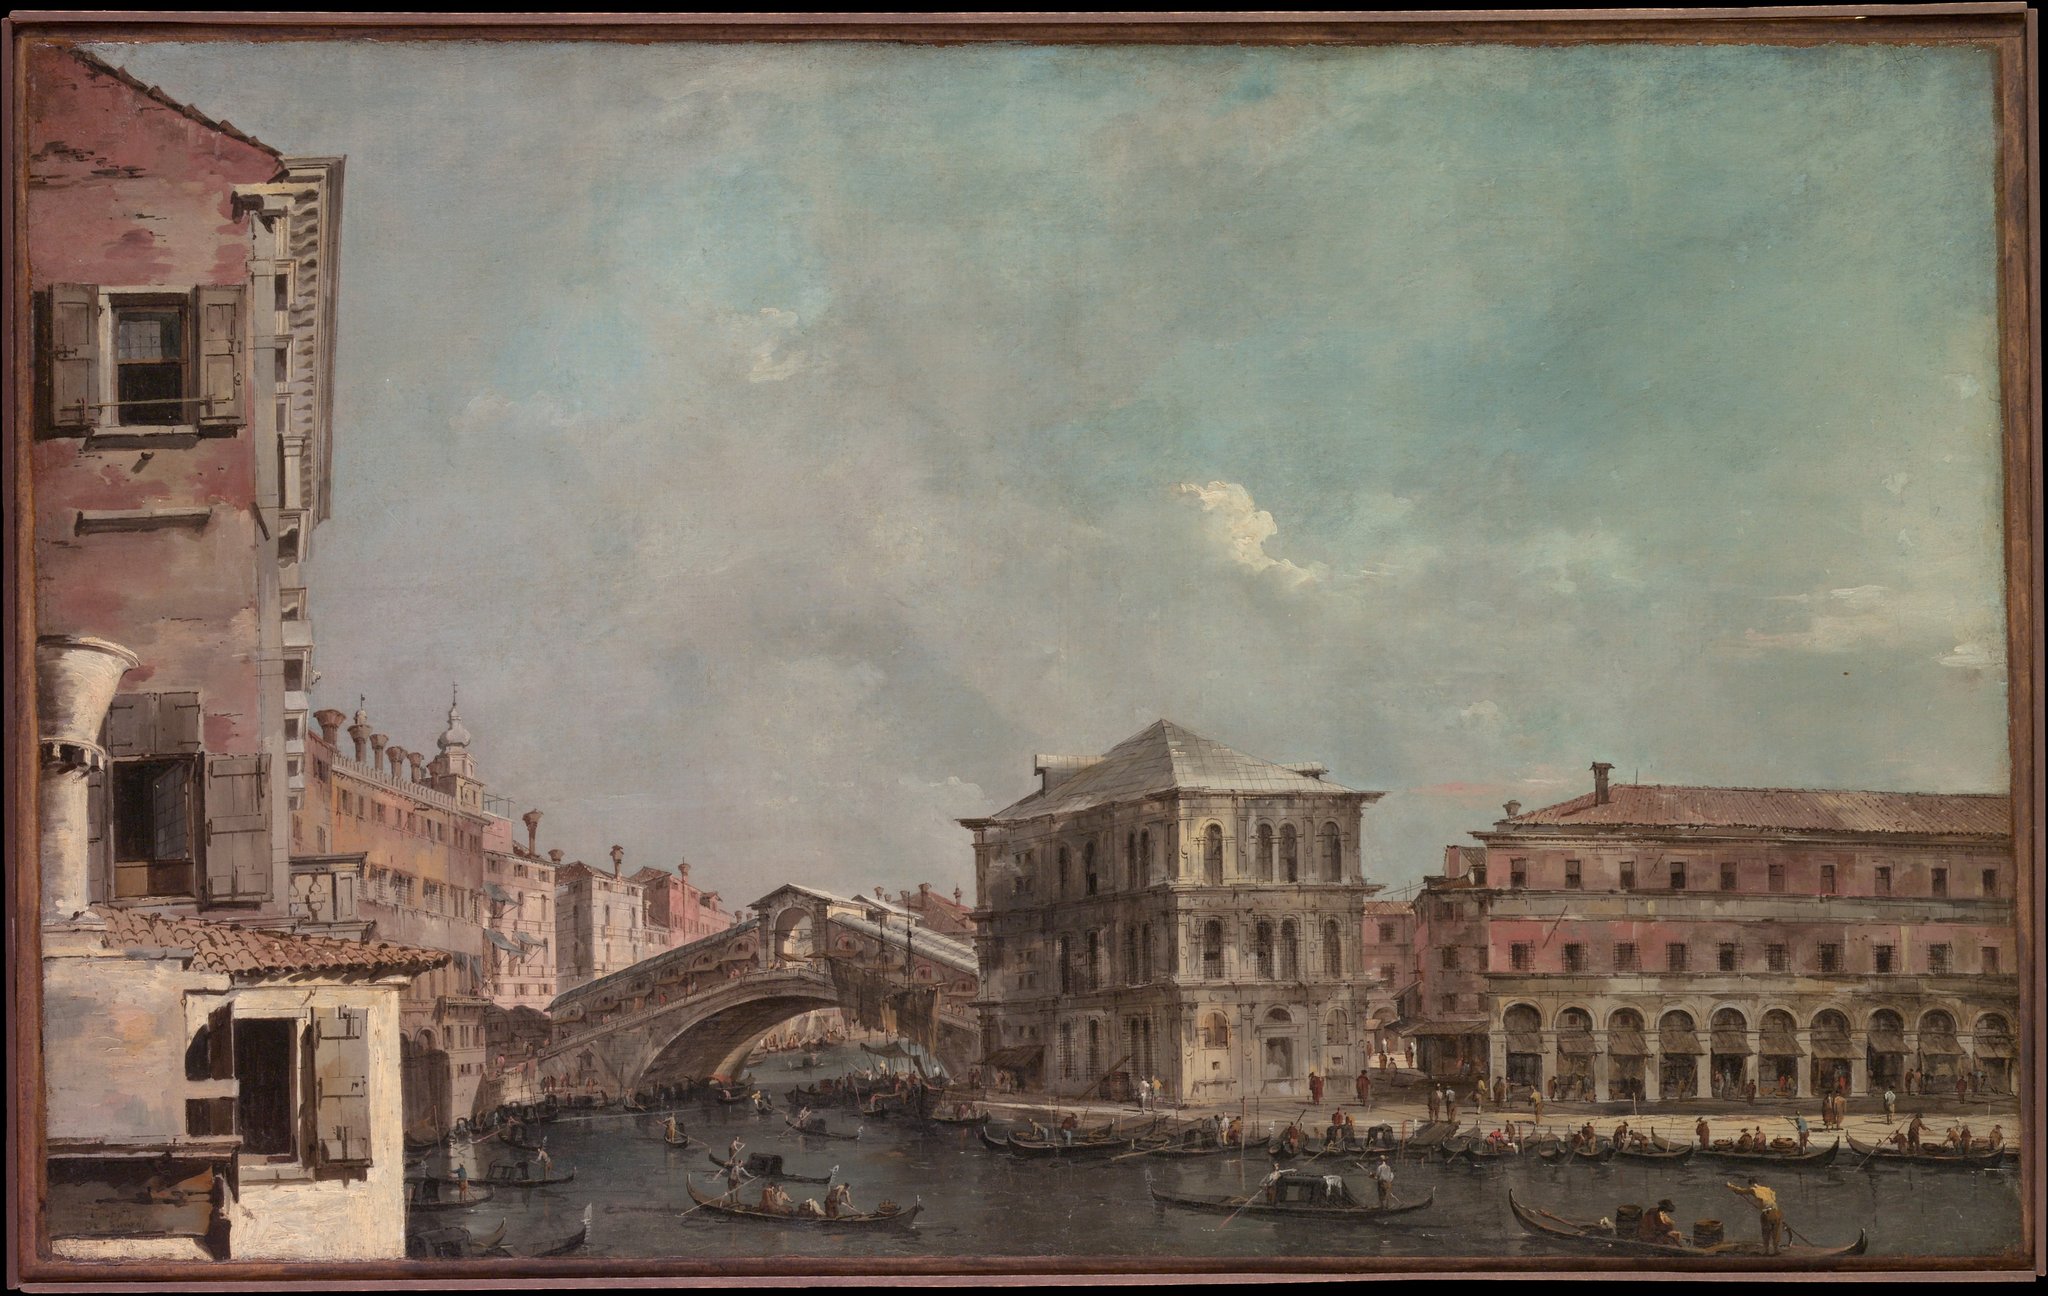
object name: painting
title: The Grand Canal above the Rialto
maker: francesco guardi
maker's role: artist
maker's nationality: italian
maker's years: 1712-1793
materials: canvas, oil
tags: buildings,cities,bridges,canals,boats,venice